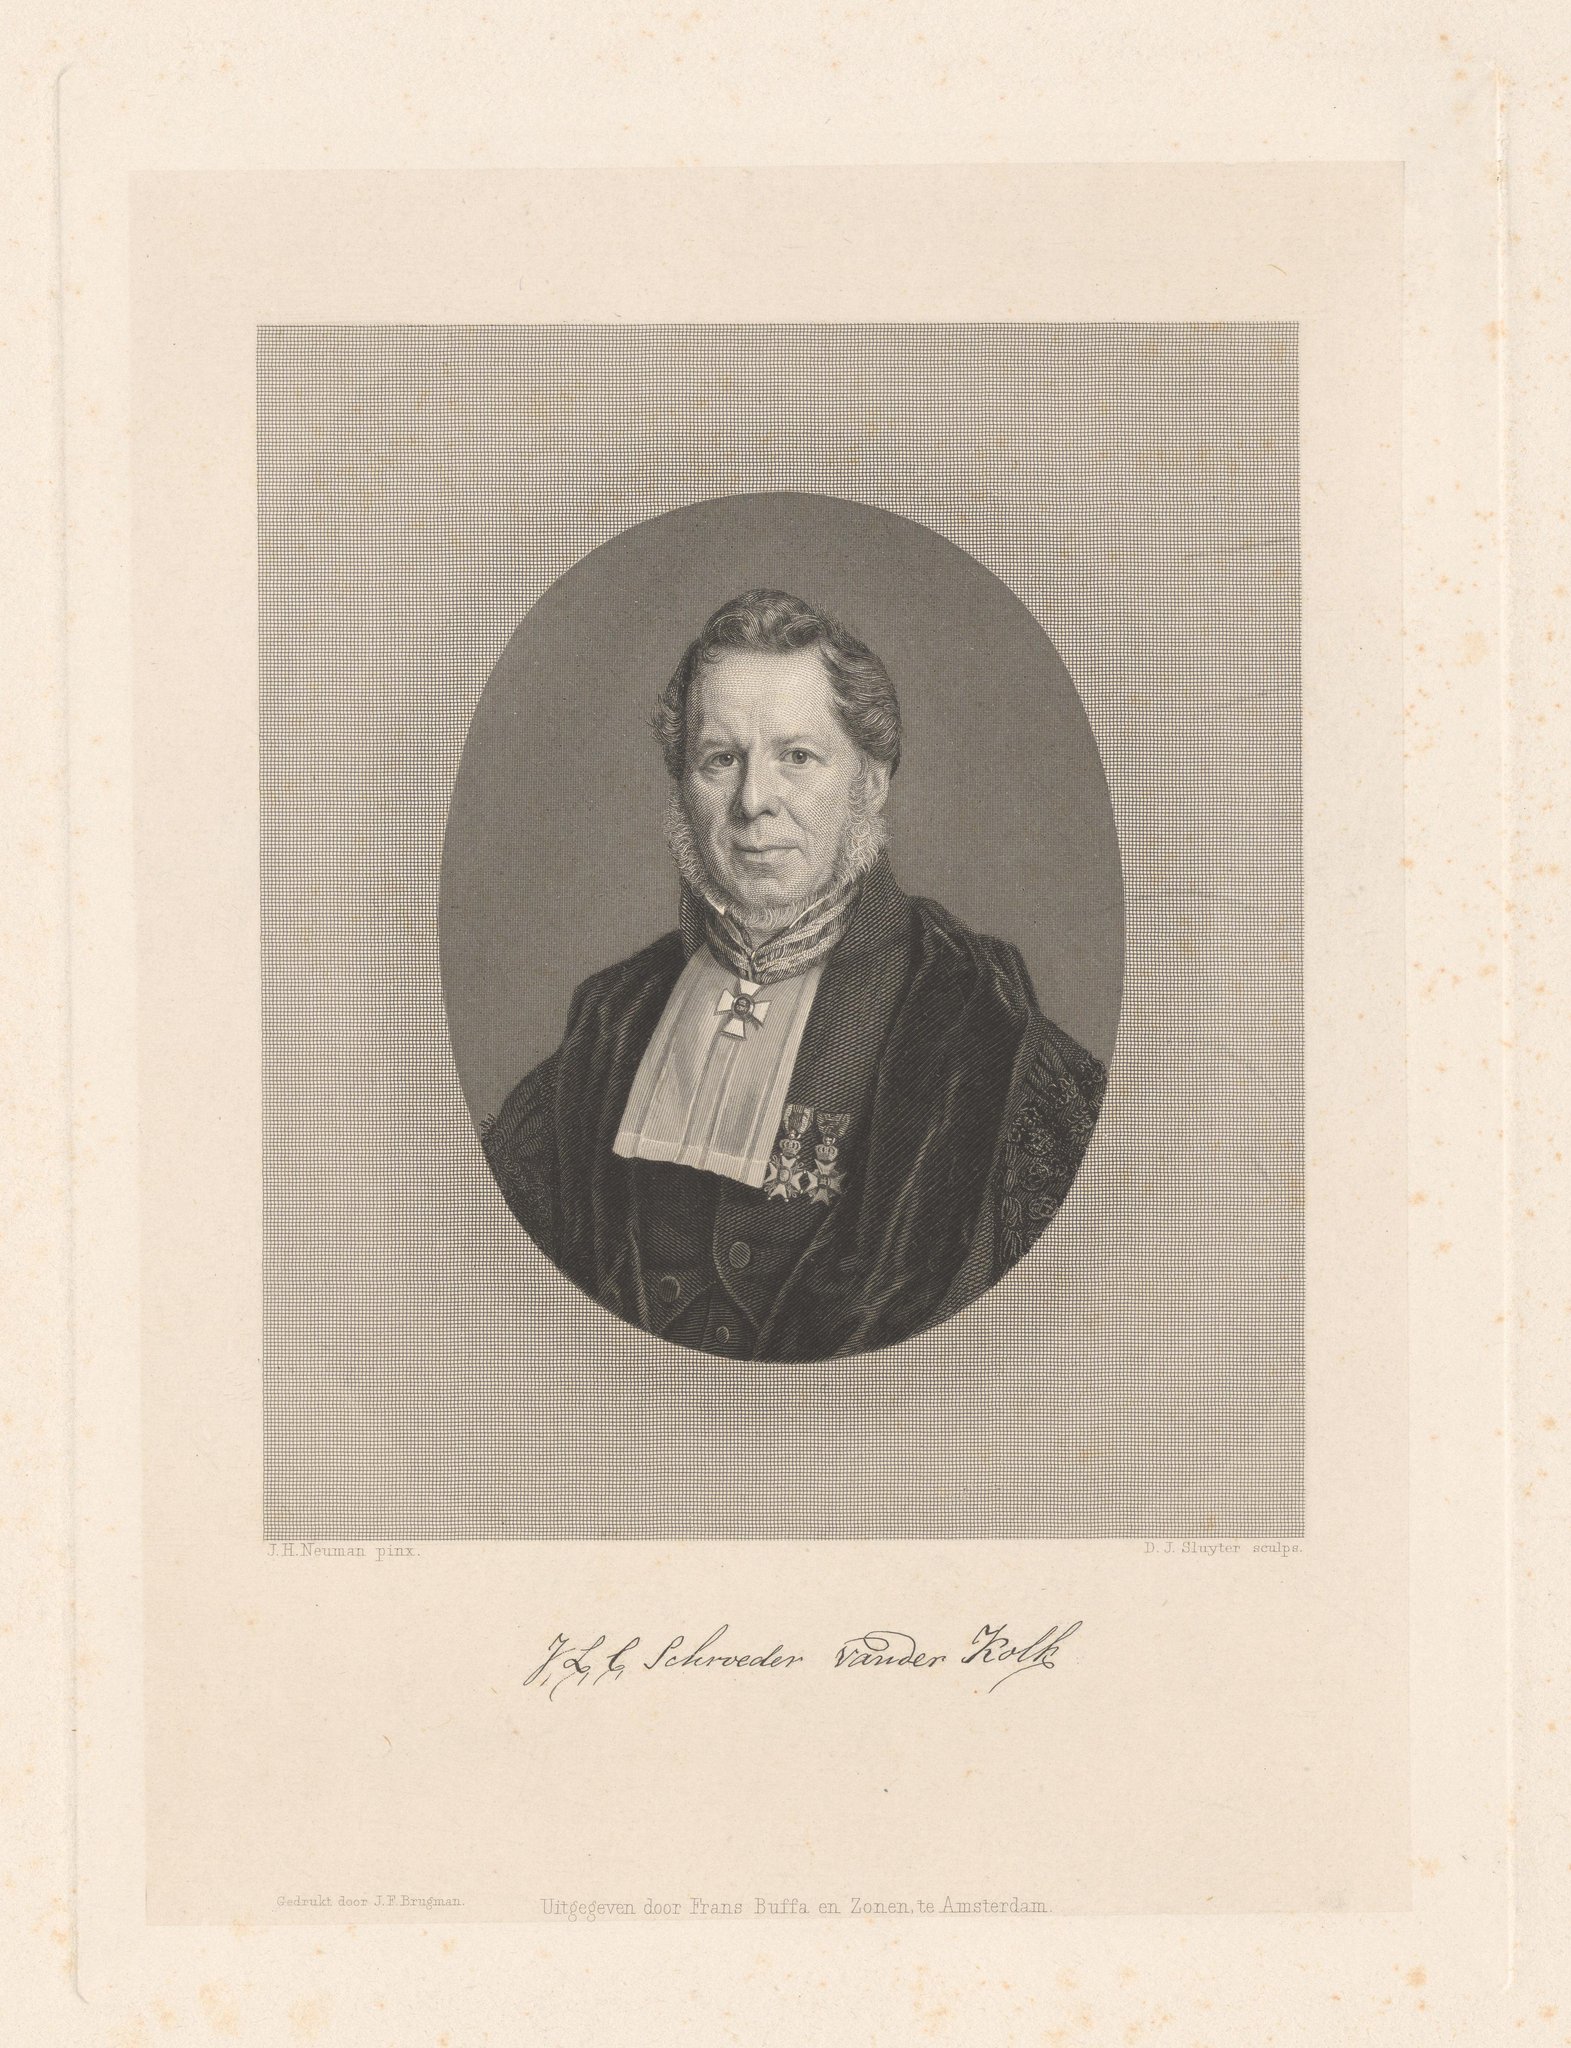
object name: print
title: Portret van Jacobus Ludovicus Conradus Schroeder van der Kolk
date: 1845-1898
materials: paper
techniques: engraving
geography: amsterdam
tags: utrecht, historical persons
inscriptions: collector's mark: Lugt 964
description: Onder het portret een facsimile van de handtekening van de geportretteerde.